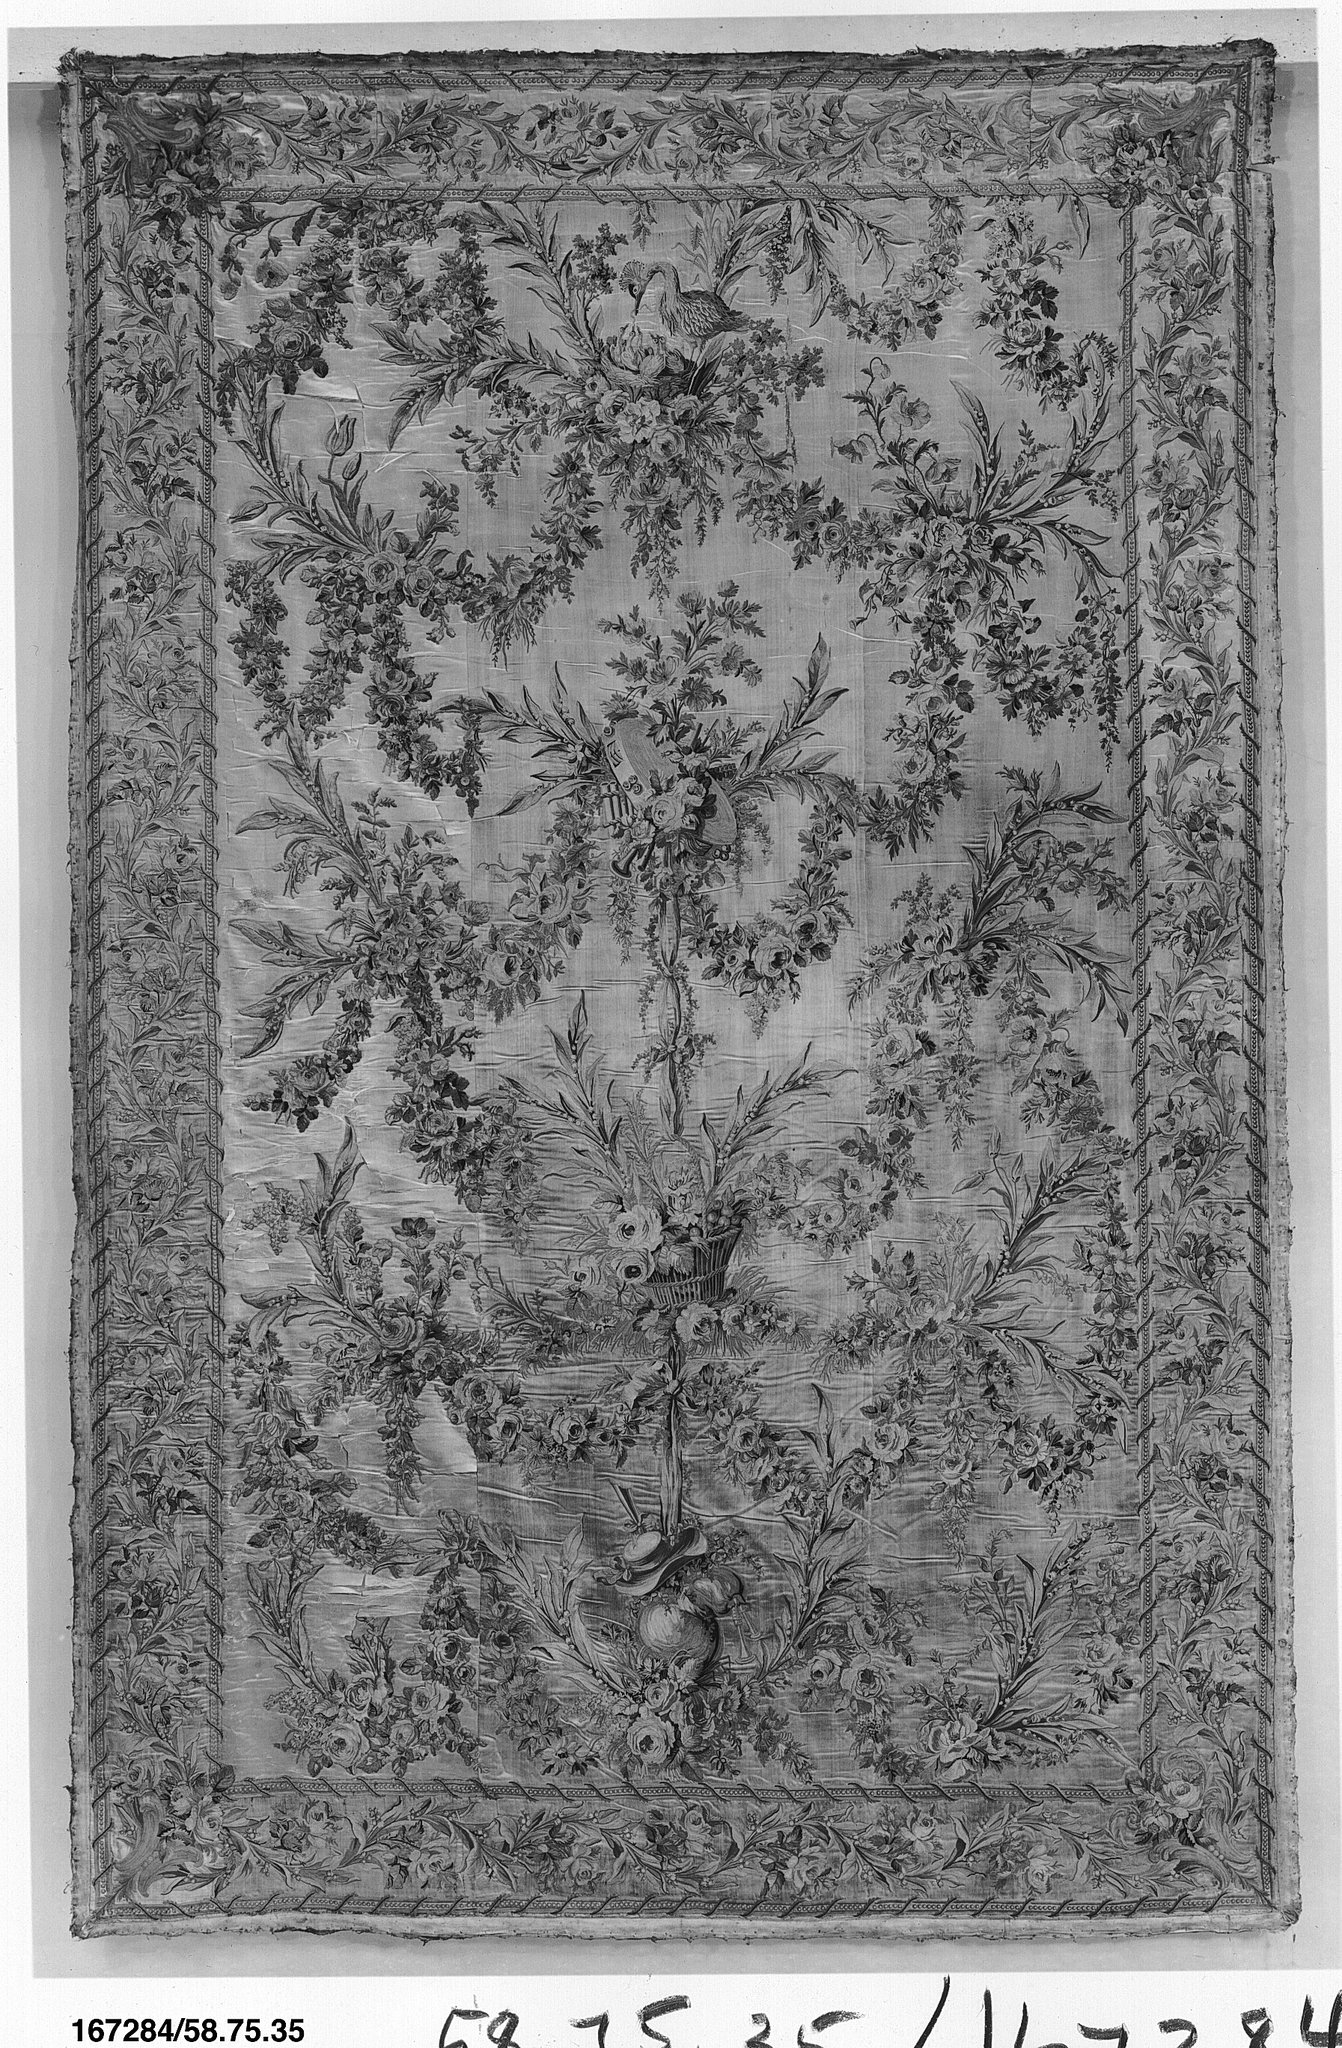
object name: wall hanging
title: Wall hangings (3)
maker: philippe de lasalle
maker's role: artist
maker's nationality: french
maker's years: 1723-1804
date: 1774-1793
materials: textile, silk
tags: birds,roses